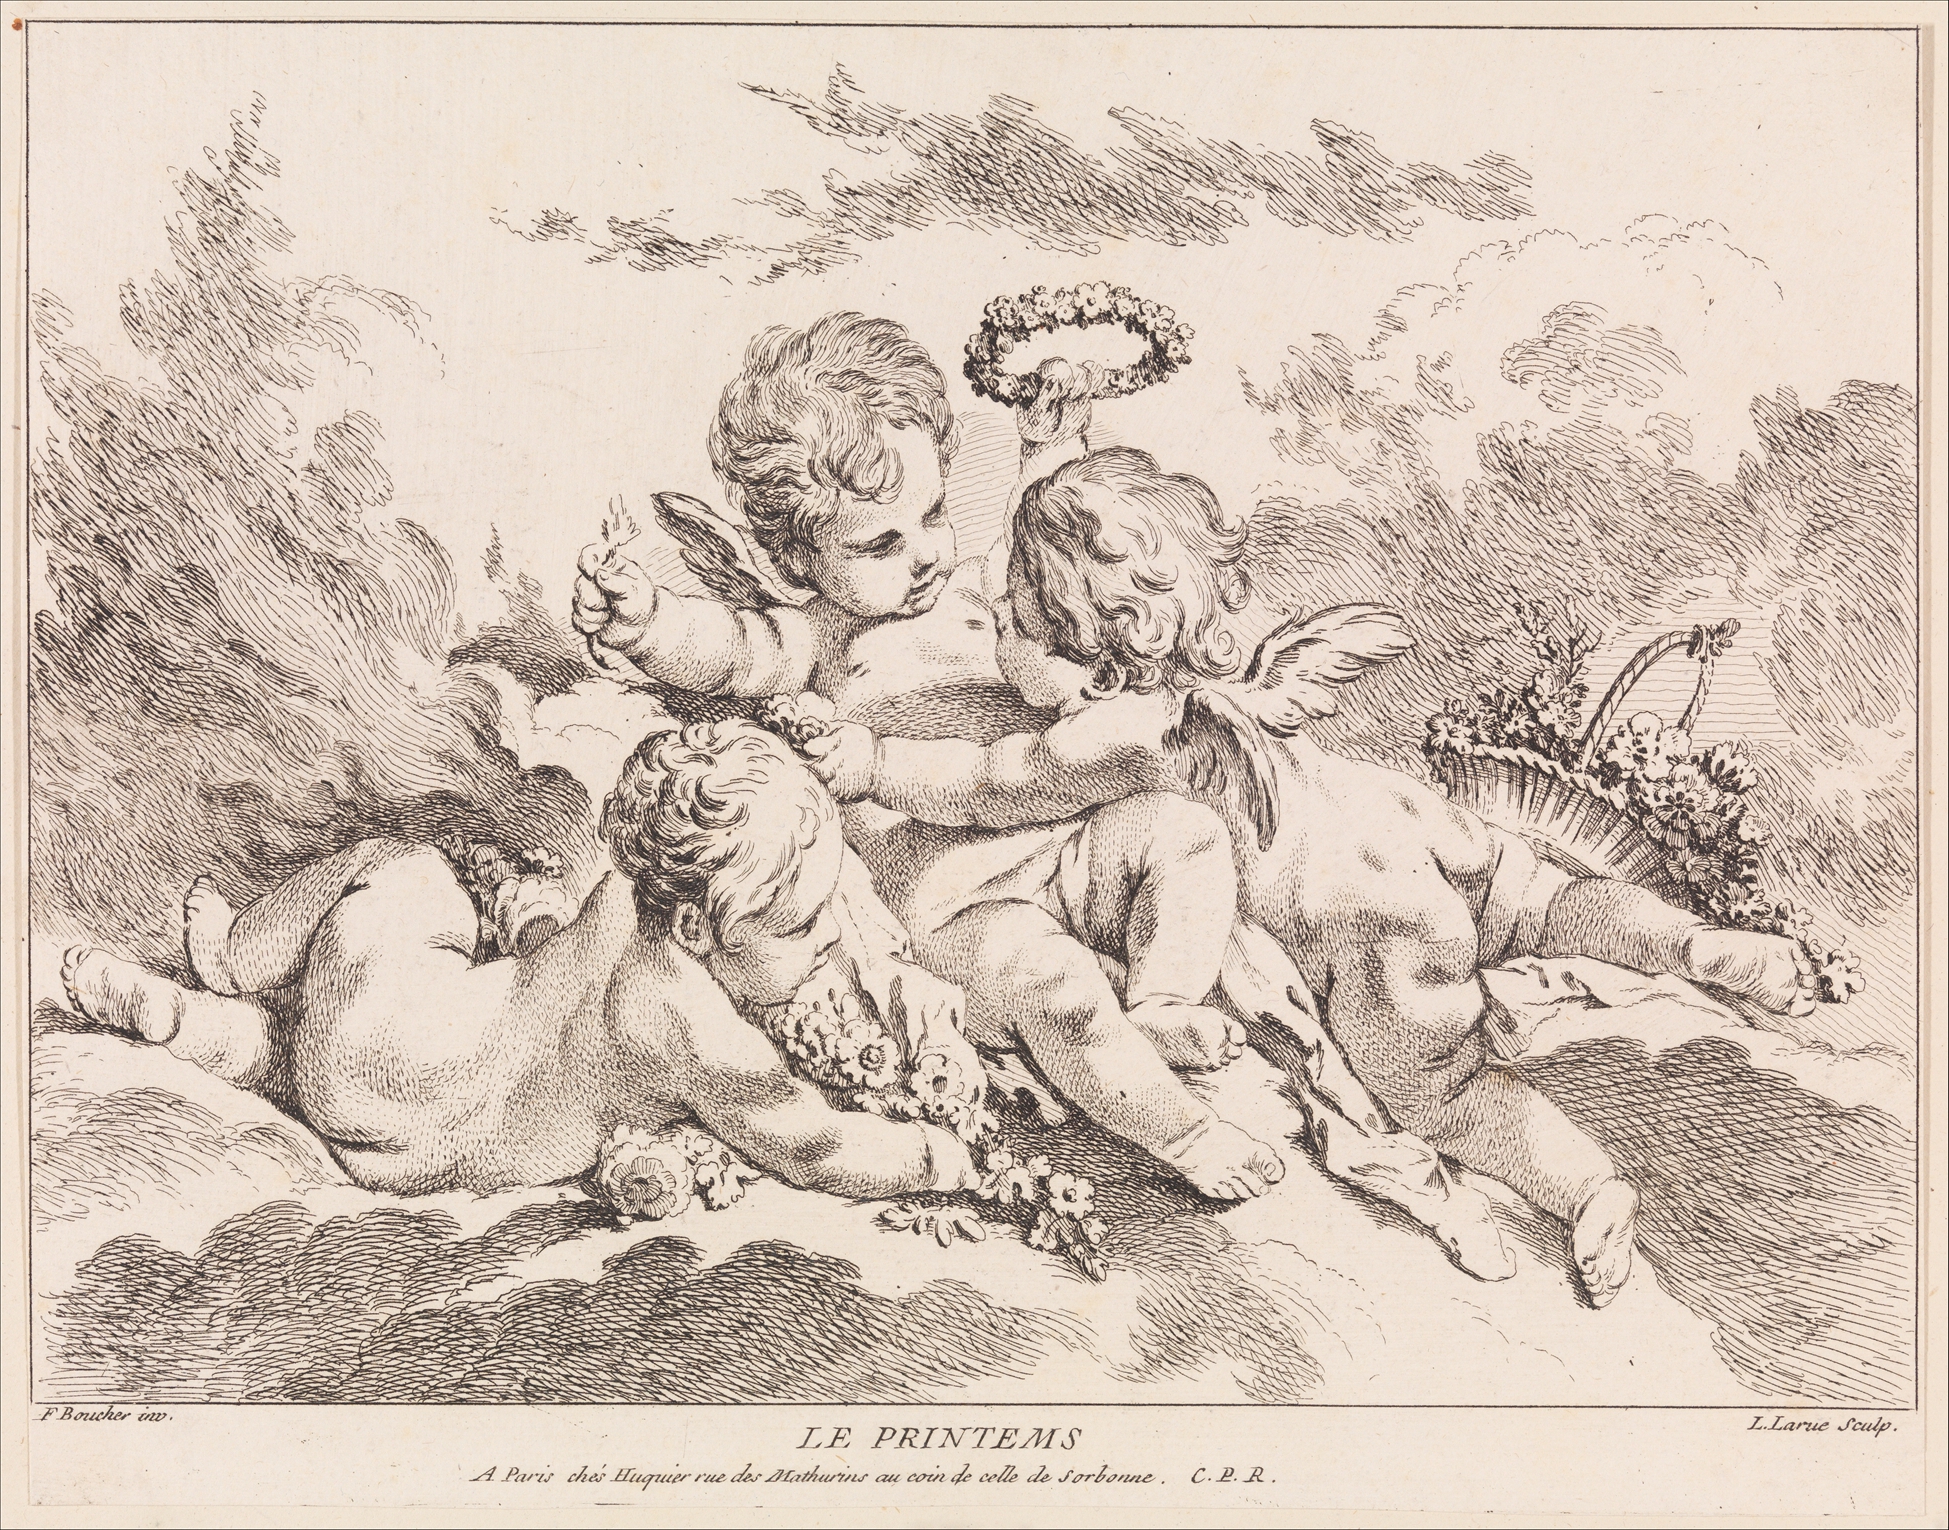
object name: print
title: Spring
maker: louis félix de la rue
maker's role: artist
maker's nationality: french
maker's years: 1731-1765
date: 1730-1777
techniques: drypoint, engraving, etching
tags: wreaths